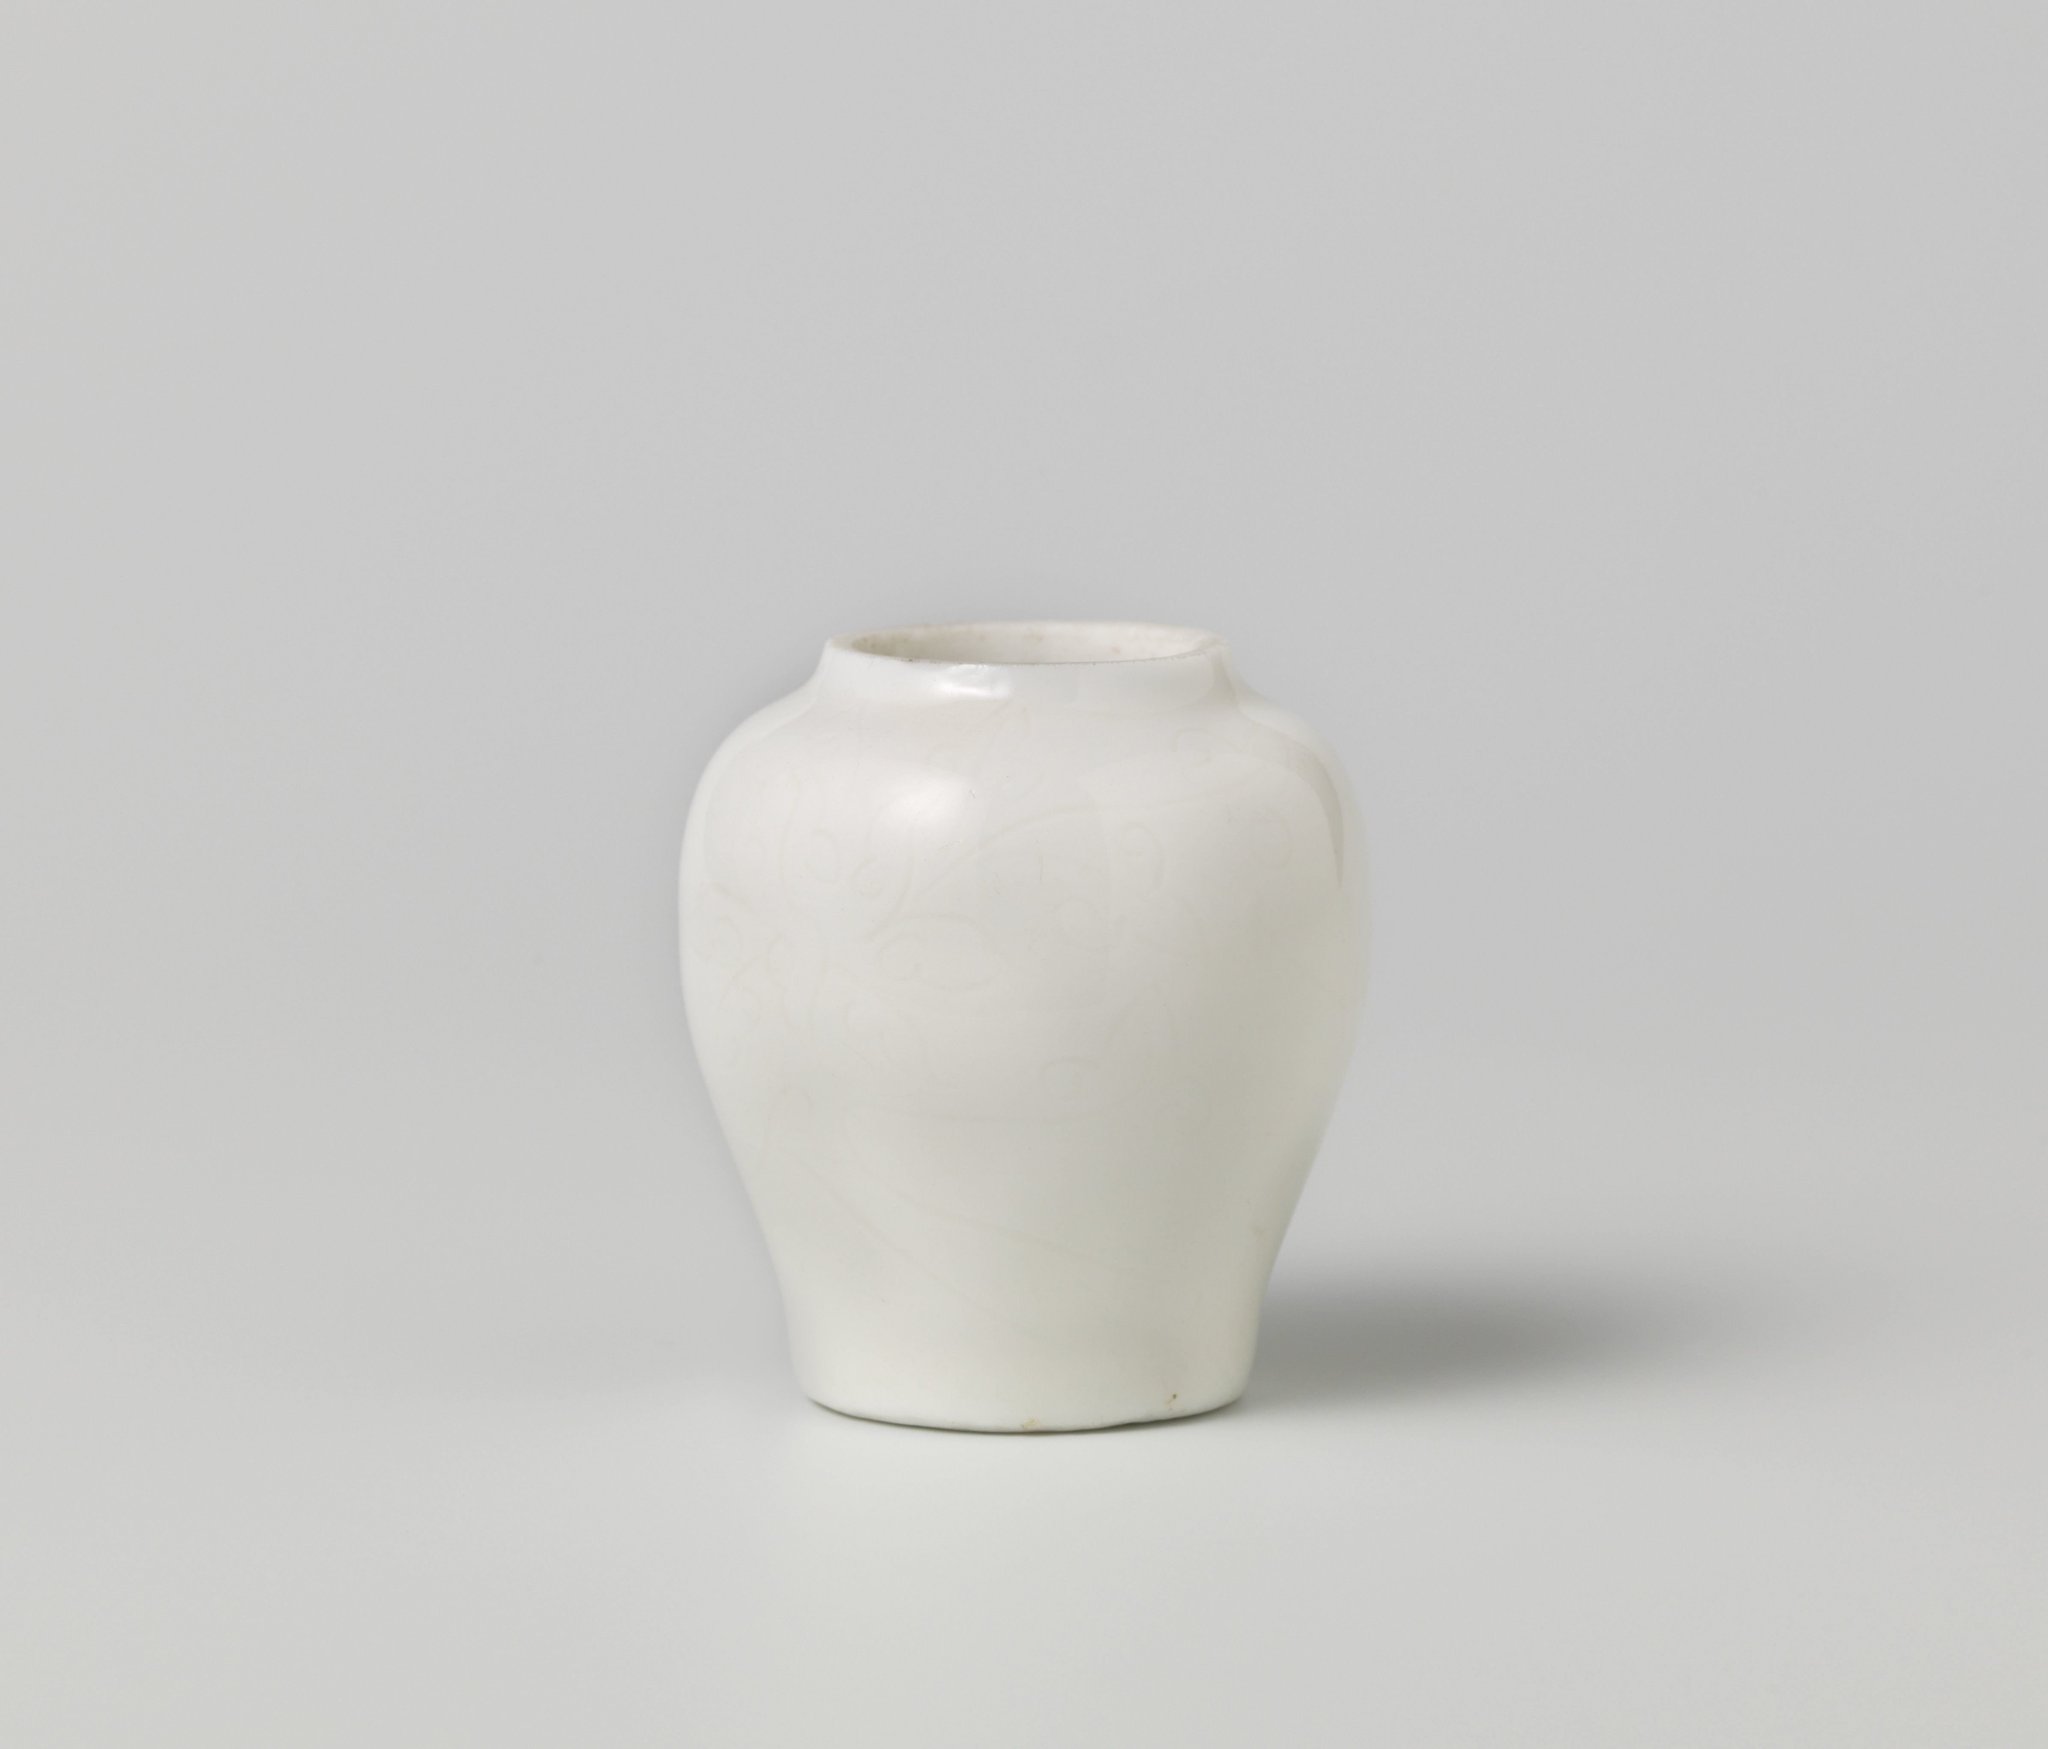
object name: vase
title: Small, baluster vase with lightly incised flower spray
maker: Anonymous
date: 1750-1774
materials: glaze, porcelain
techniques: firing, turning, vitrification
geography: china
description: AK-NM-6533 Twee kleine balustervormige vazen • Dehua blanc de China • Onderdeel van Royers studiecollectie (inventaris Van de Kasteele 1816, nr. 287) • Mogelijk afkomstig van Susanna Louisa Huygens Het is opmerkelijk dat in de rubriek ‘Wit Porceleyn Beeldwerk’ in de boedelbeschrijving van Royers oudtante Susanna Louisa Huygens (1714-1785) blijkbaar ook vaatwerk voorkwam. We treffen daar ‘Twee tonnetjes en een kannetje dito [met bloemen, opwerk] met oiren’. Mogelijk zijn Royers vaasjes de twee tonnetjes uit deze beschrijving, al zijn de bloemtakken ingegrift en geen ‘opwerk’, reliëf. Royer nam veel porselein over uit de nalatenschap van zijn oudtante, maar er is helaas niet precies vastgelegd welke stukken.